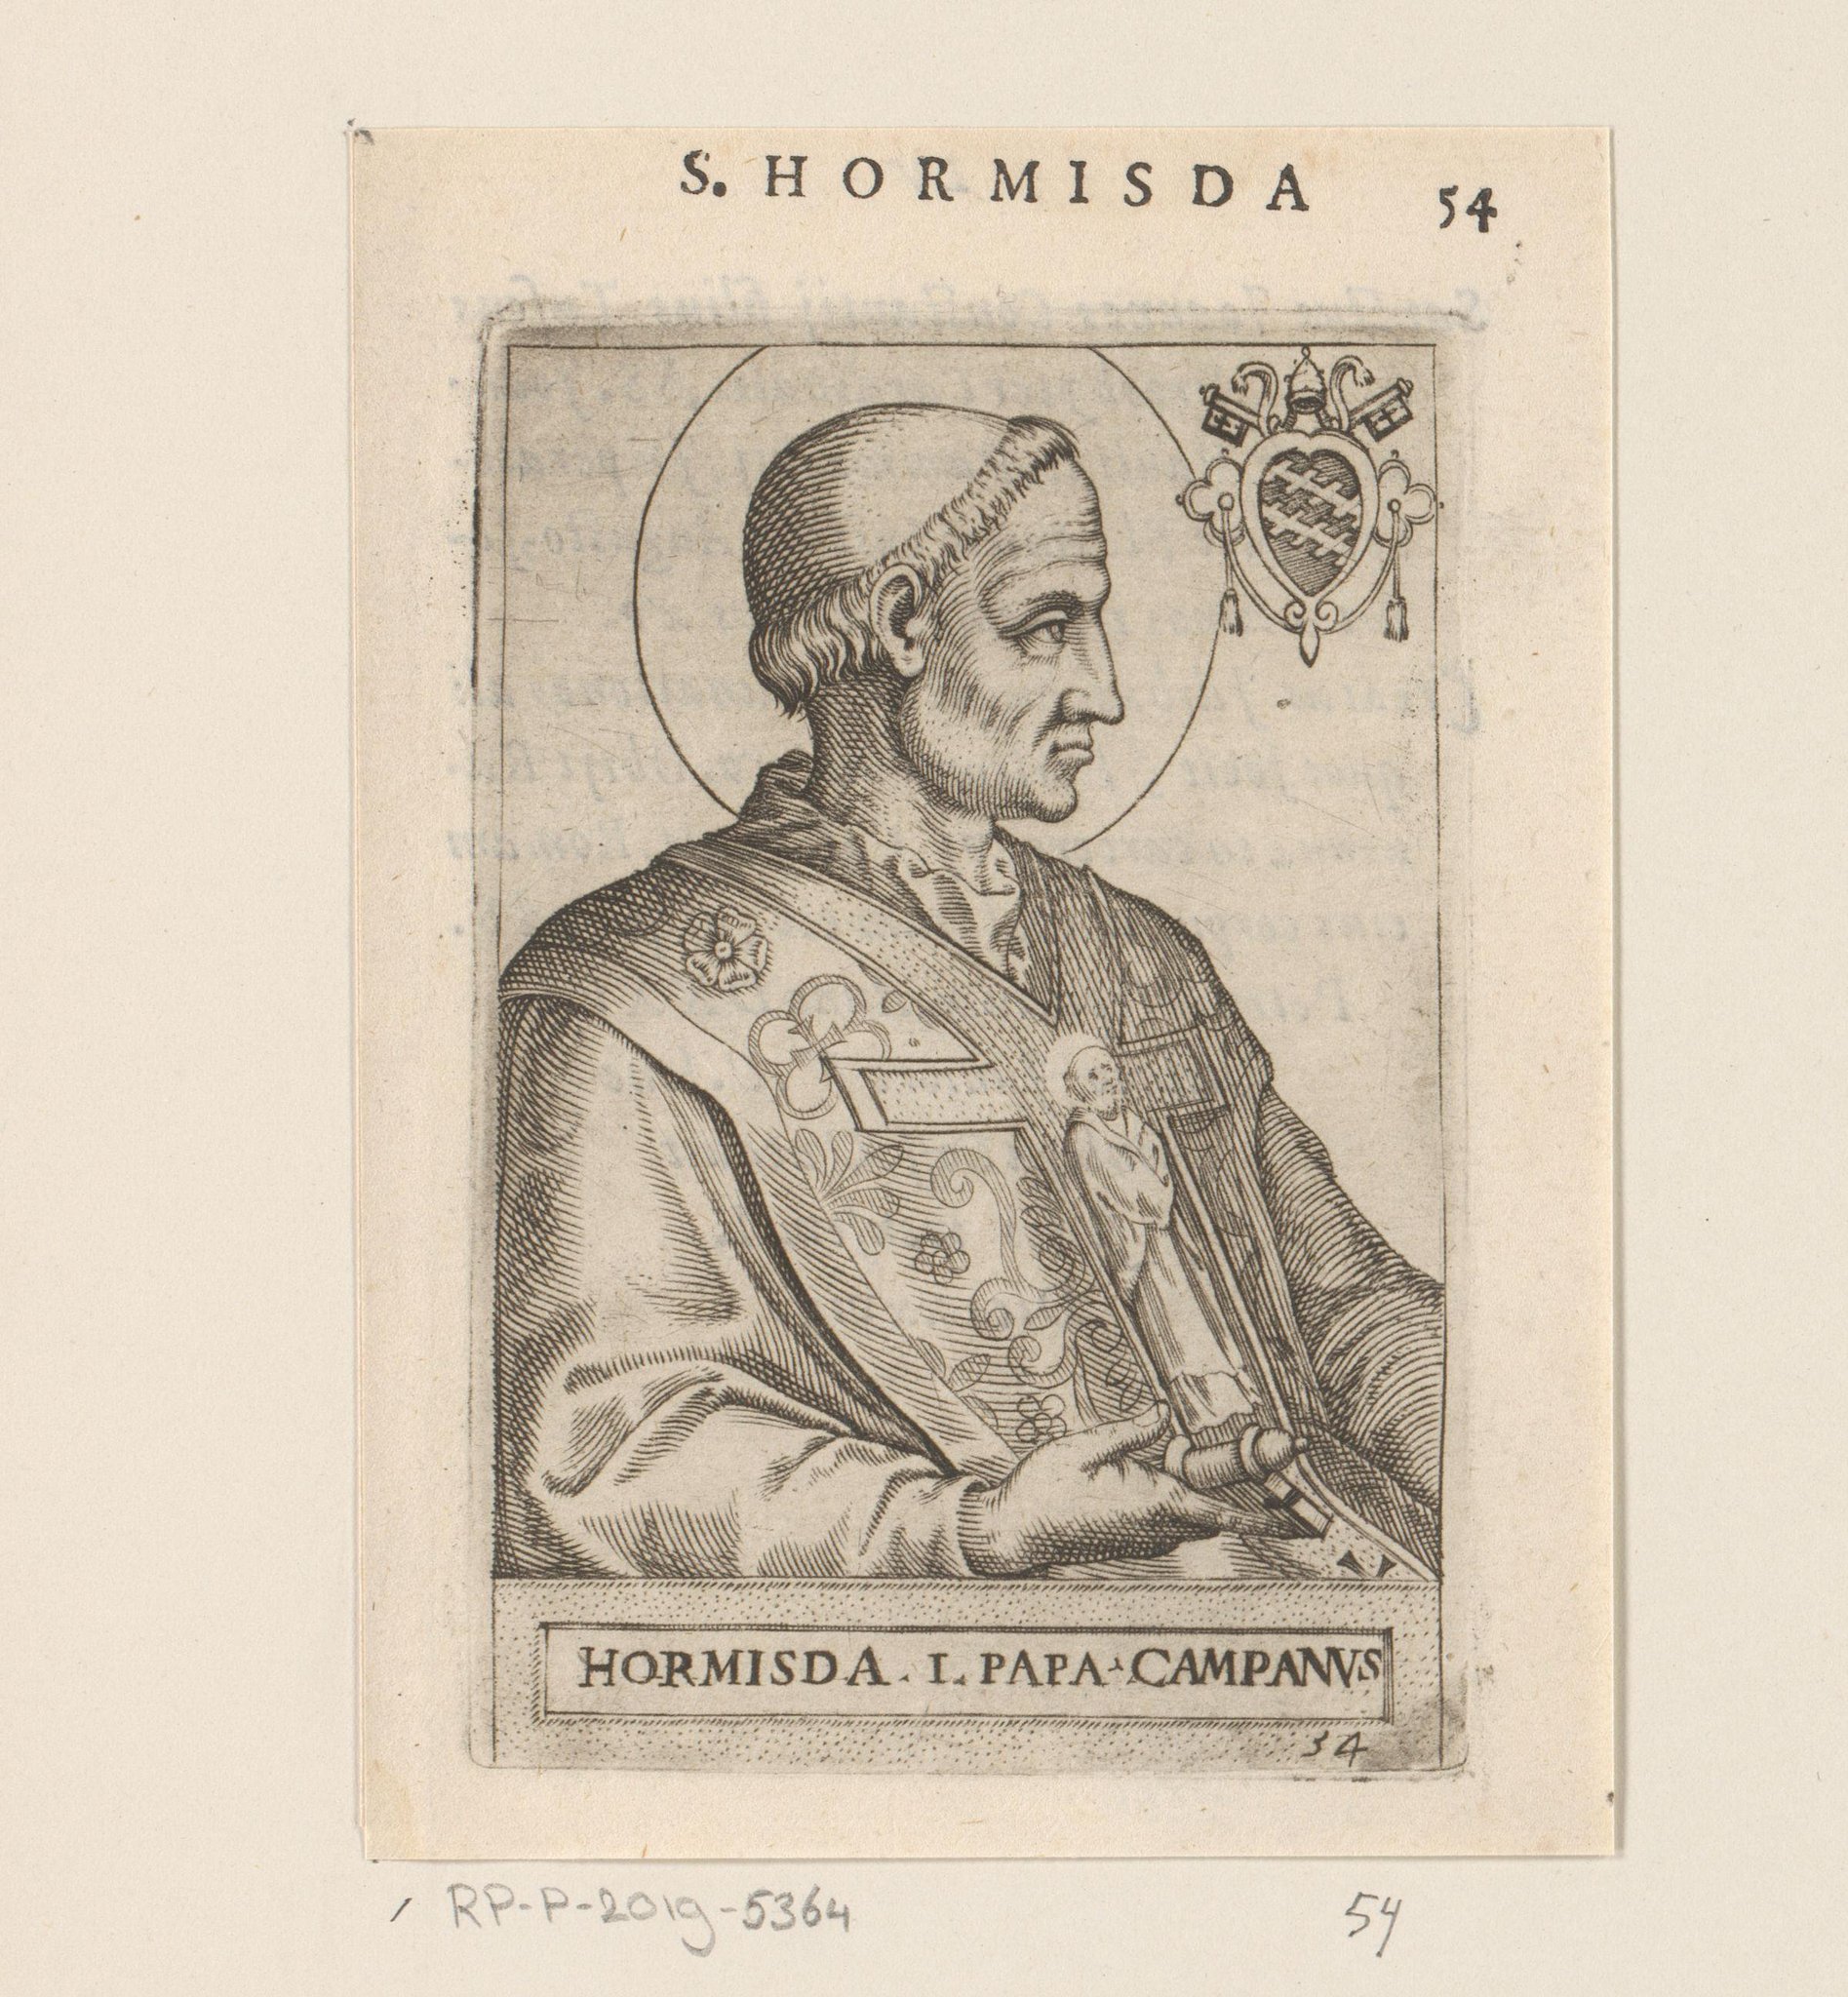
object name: book illustration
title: Hormisda I Papa Campanus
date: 1595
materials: paper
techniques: engraving, letterpress printing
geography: rome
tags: rome, historical persons, pope, armorial bearing, heraldry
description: Prent uit: Cavalieri, Giovanni Battista de'. Effigies pontificum romanorum cum eorum vitis (...). Rome: Bartolomeo Bonfadino, 1595. Prent voor het eerst verschenen in: Cavalieri, Giovanni Battista de'. Pontificum romanorum effigies (...). Rome: Domenico Basa en Francesco Zanetti, 1580. Prent ook gebruikt in latere publicaties.